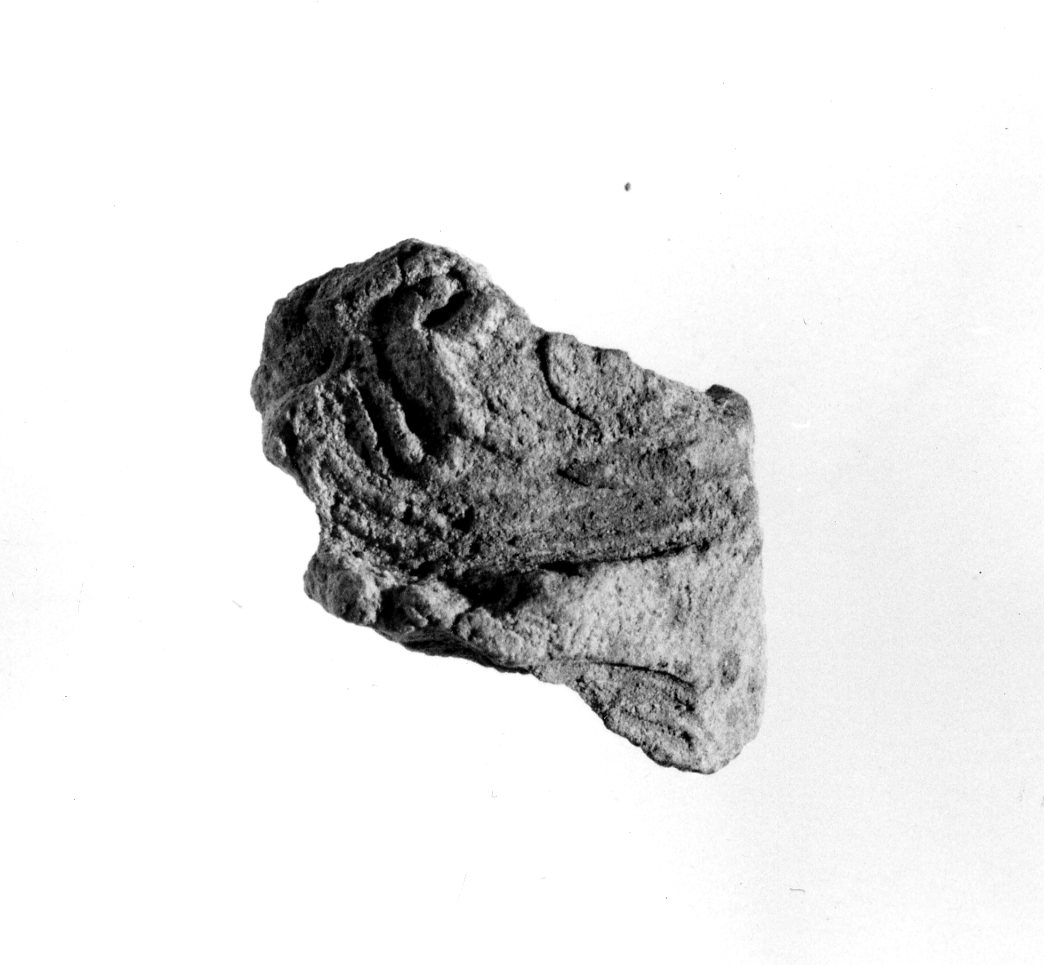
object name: sealing, amenhotep iii, nebmaatre. winged cobra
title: Document Sealing with the Throne Name of Amenhotep III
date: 1390-1352 BCE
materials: mud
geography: egypt